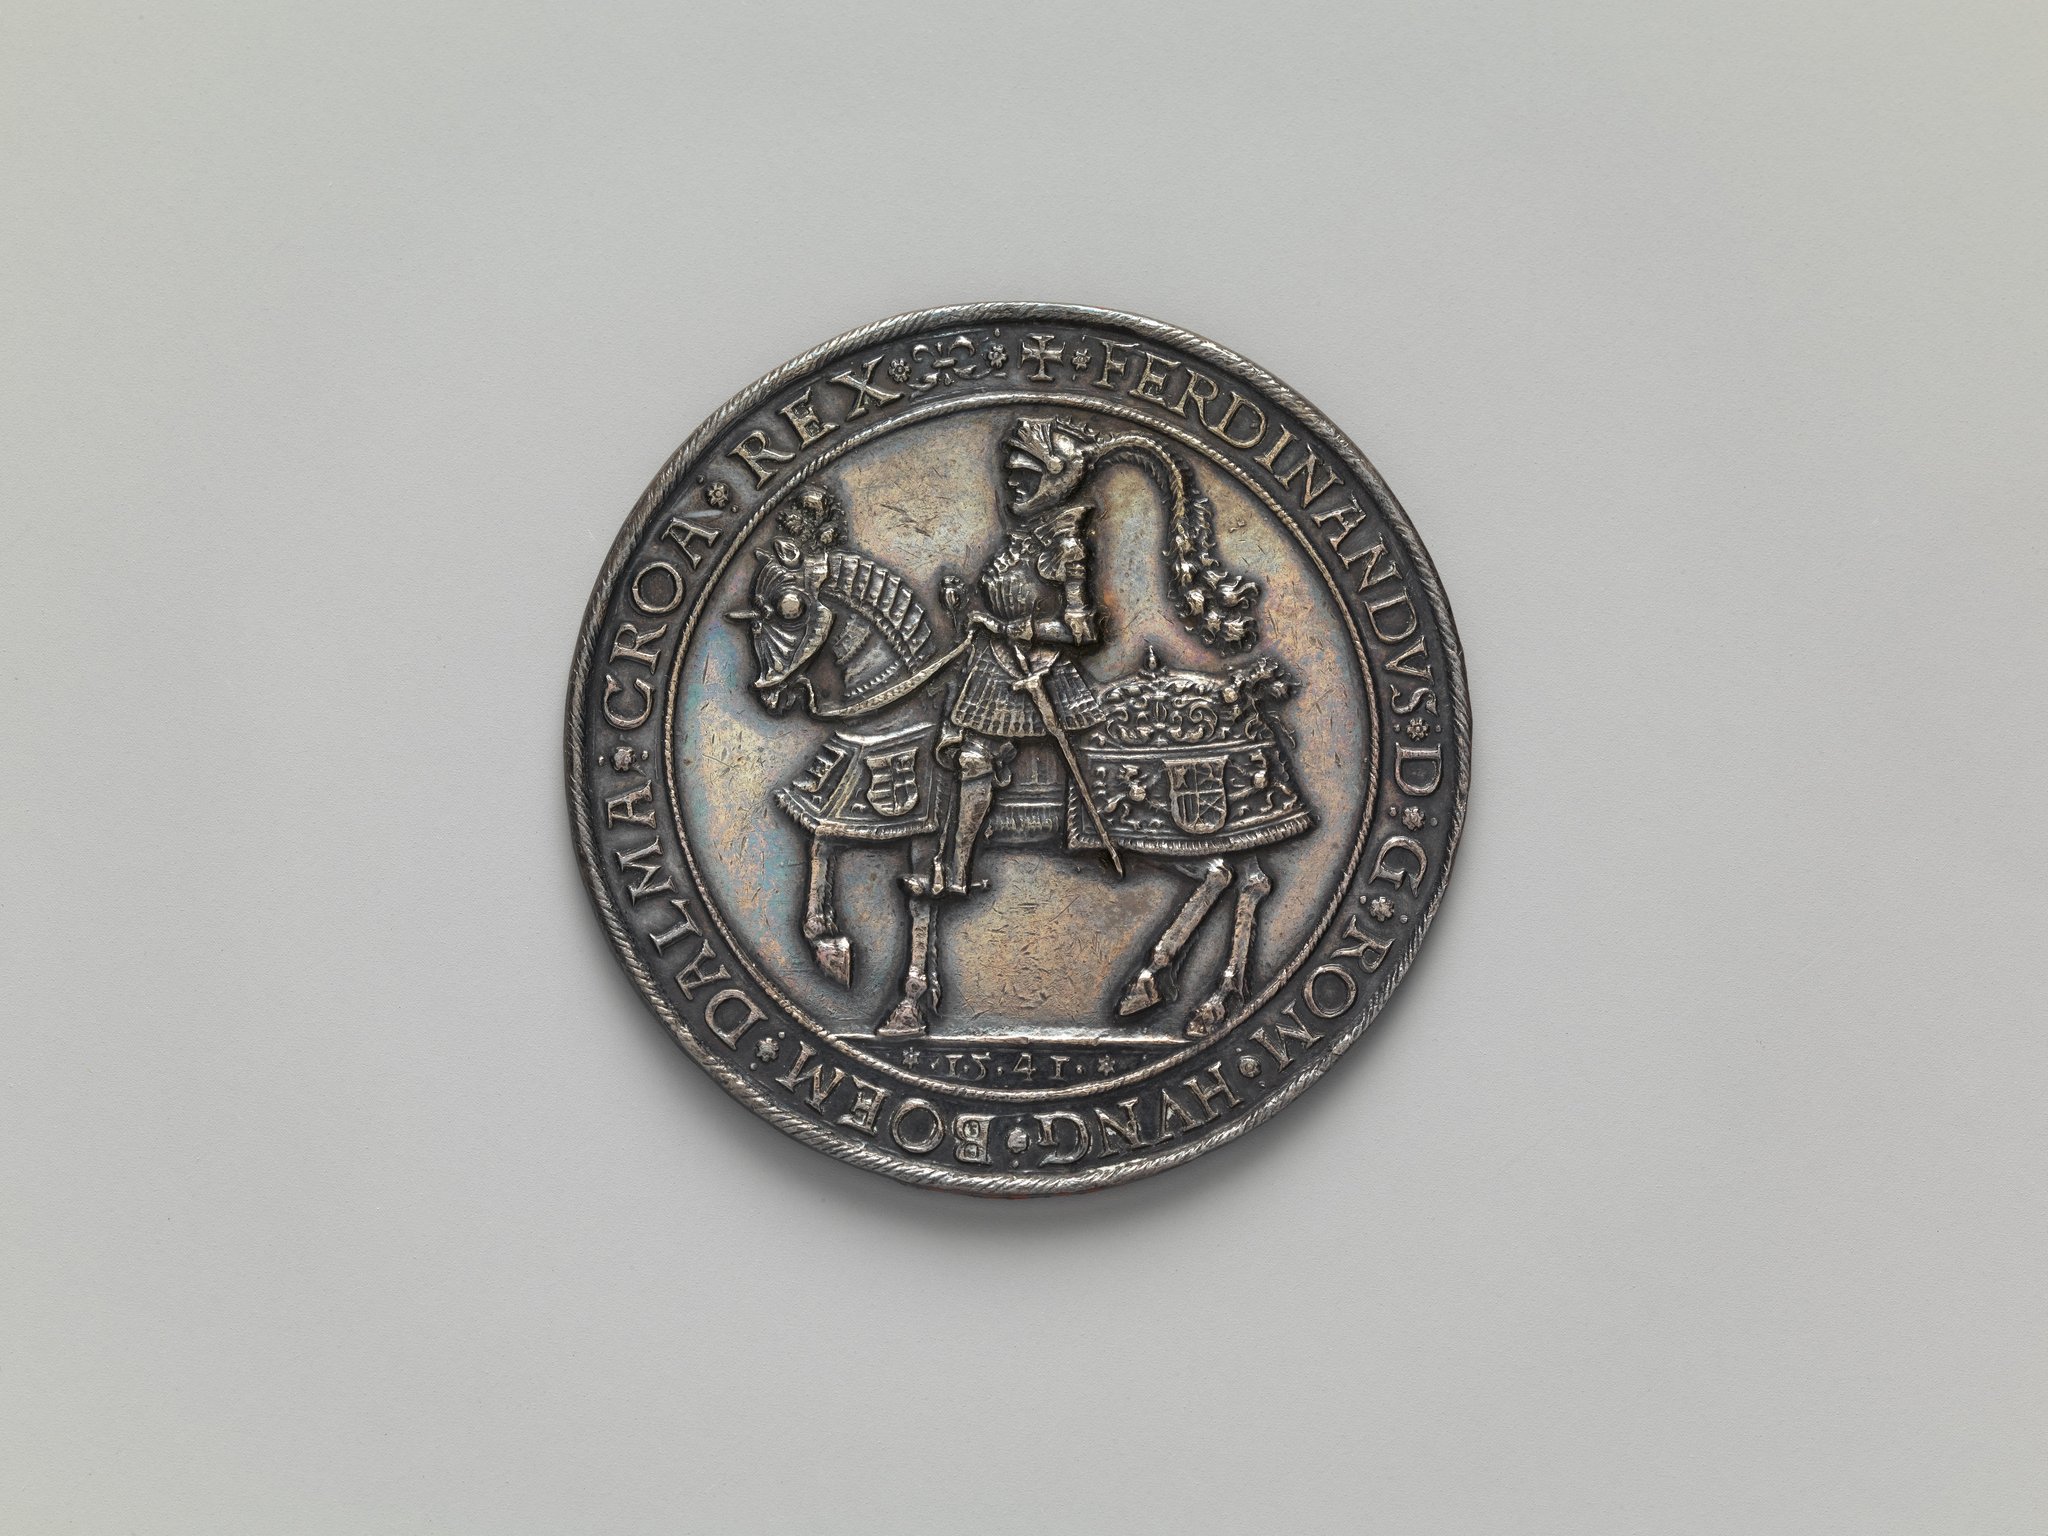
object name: thaler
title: Wide Show-Thaler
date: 1541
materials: silver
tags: horses,coins,coat of arms